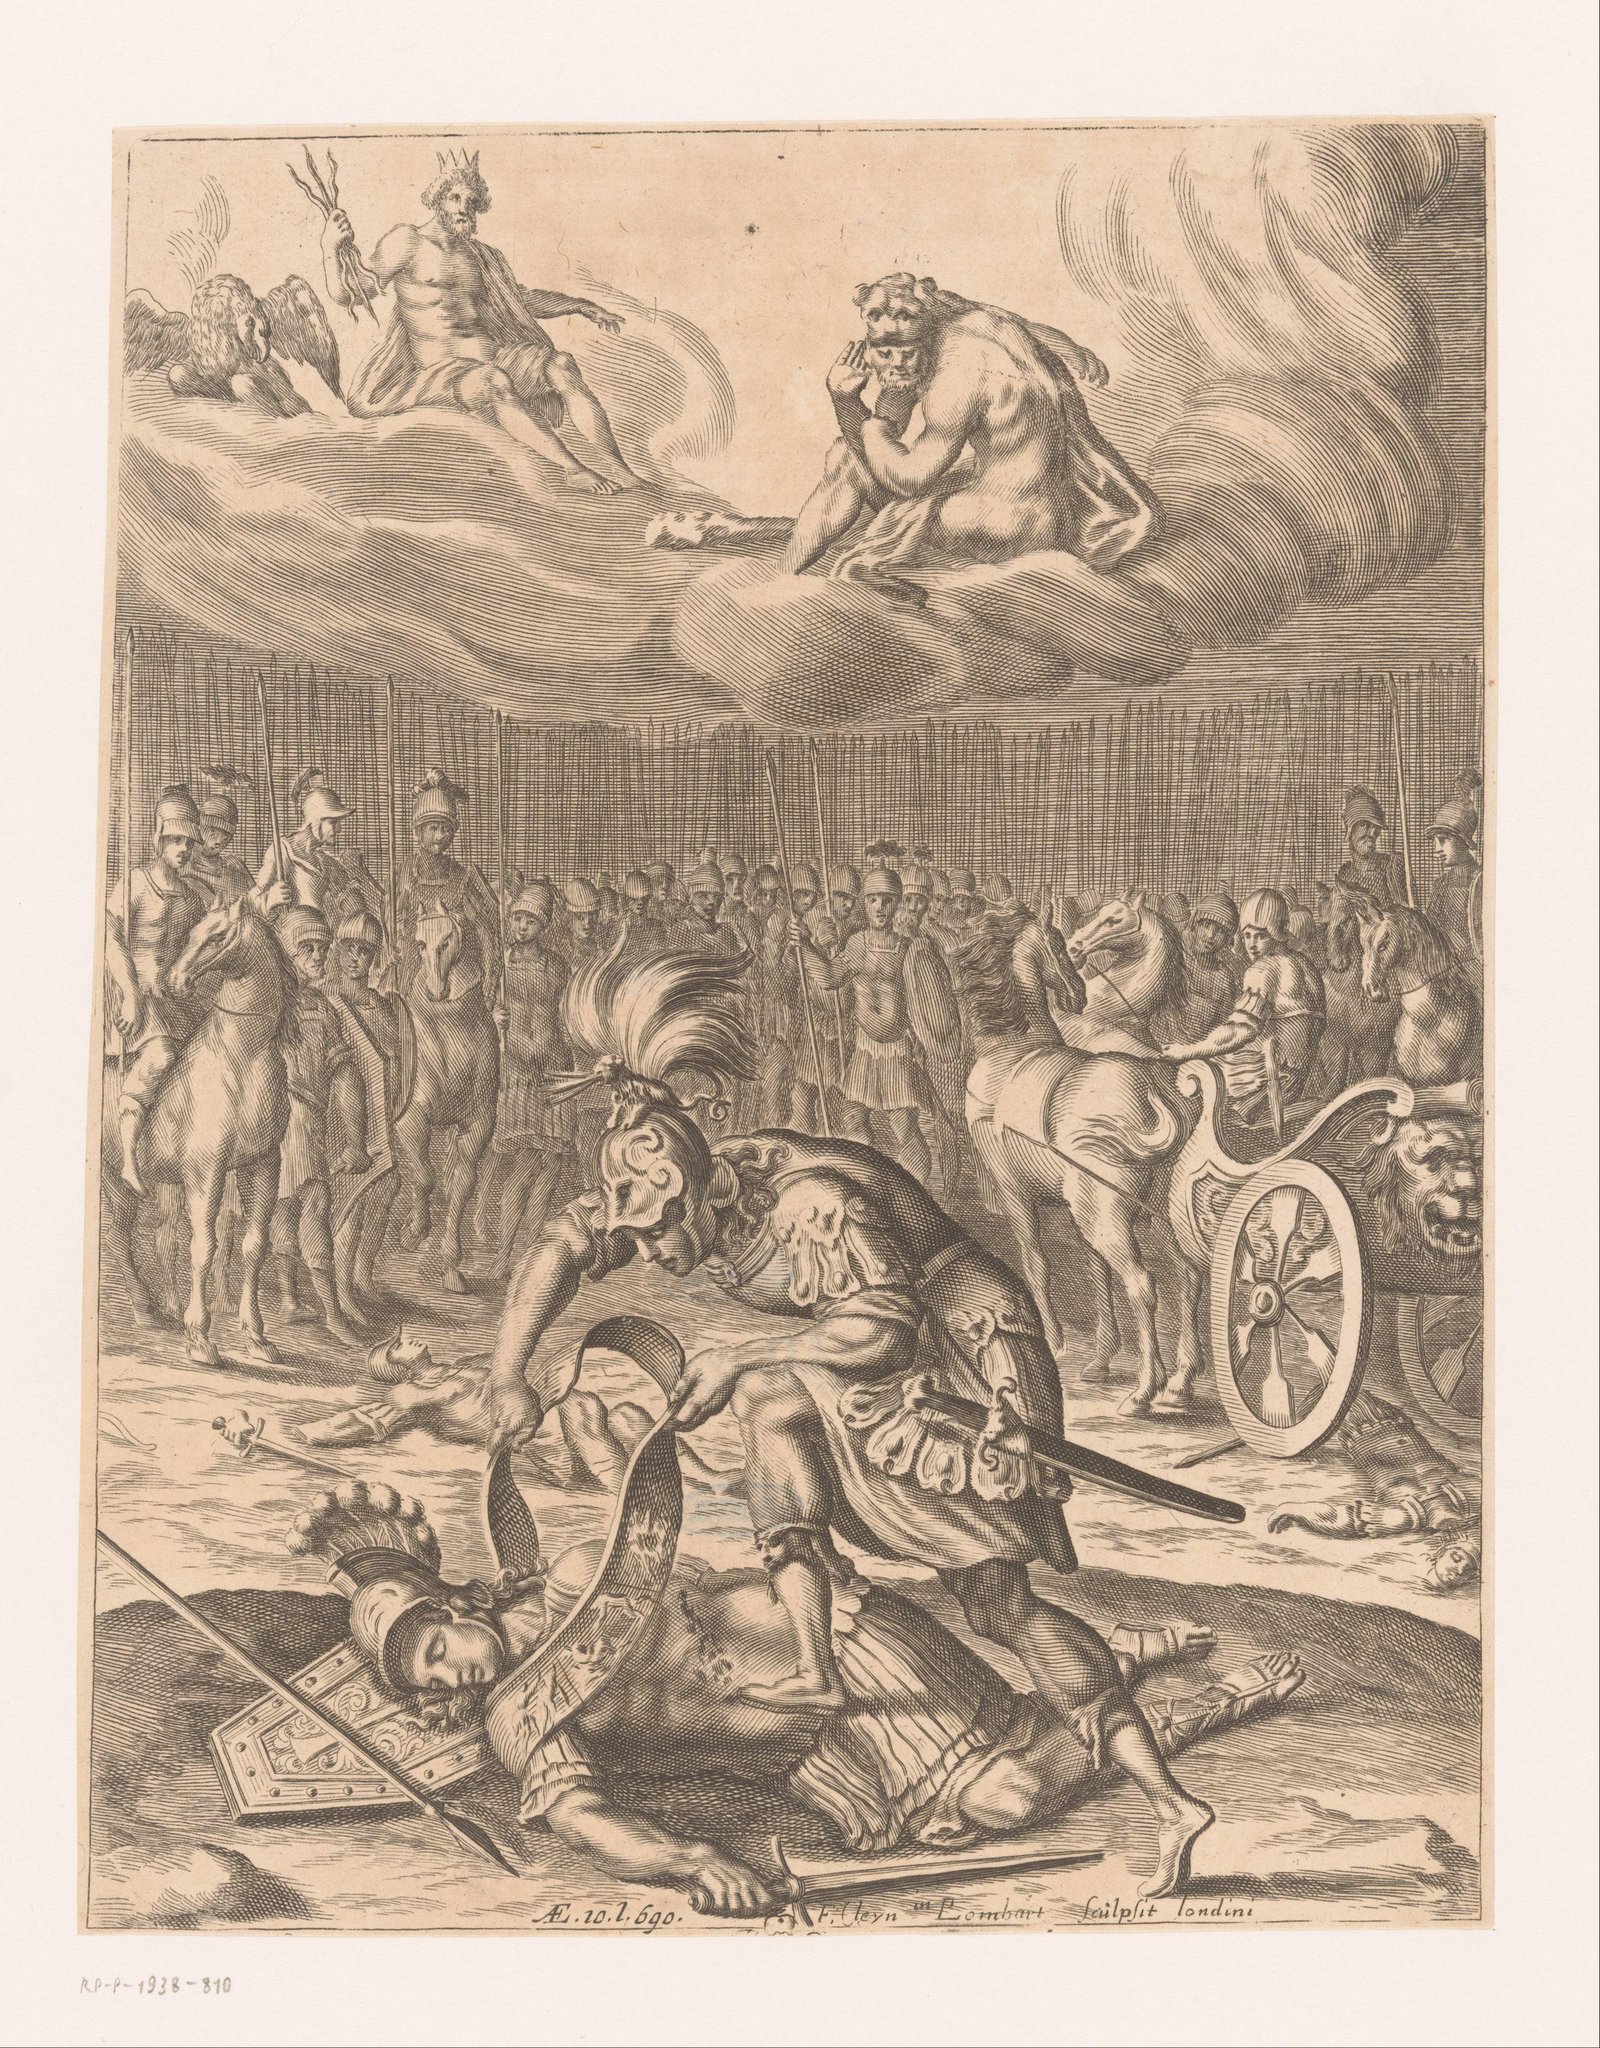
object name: print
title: Slagveld met Jupiter en Hercules in de wolken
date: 1654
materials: paper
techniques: engraving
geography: london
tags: (story of) hercules (heracles), (story of) jupiter (zeus), battle, violent death by beheading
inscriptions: collector's mark: Lugt 2228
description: Waarschijnlijk prent uit: Ogilby, John. The works of Publius Virgilius Maro. Londen: s.n; 1654.